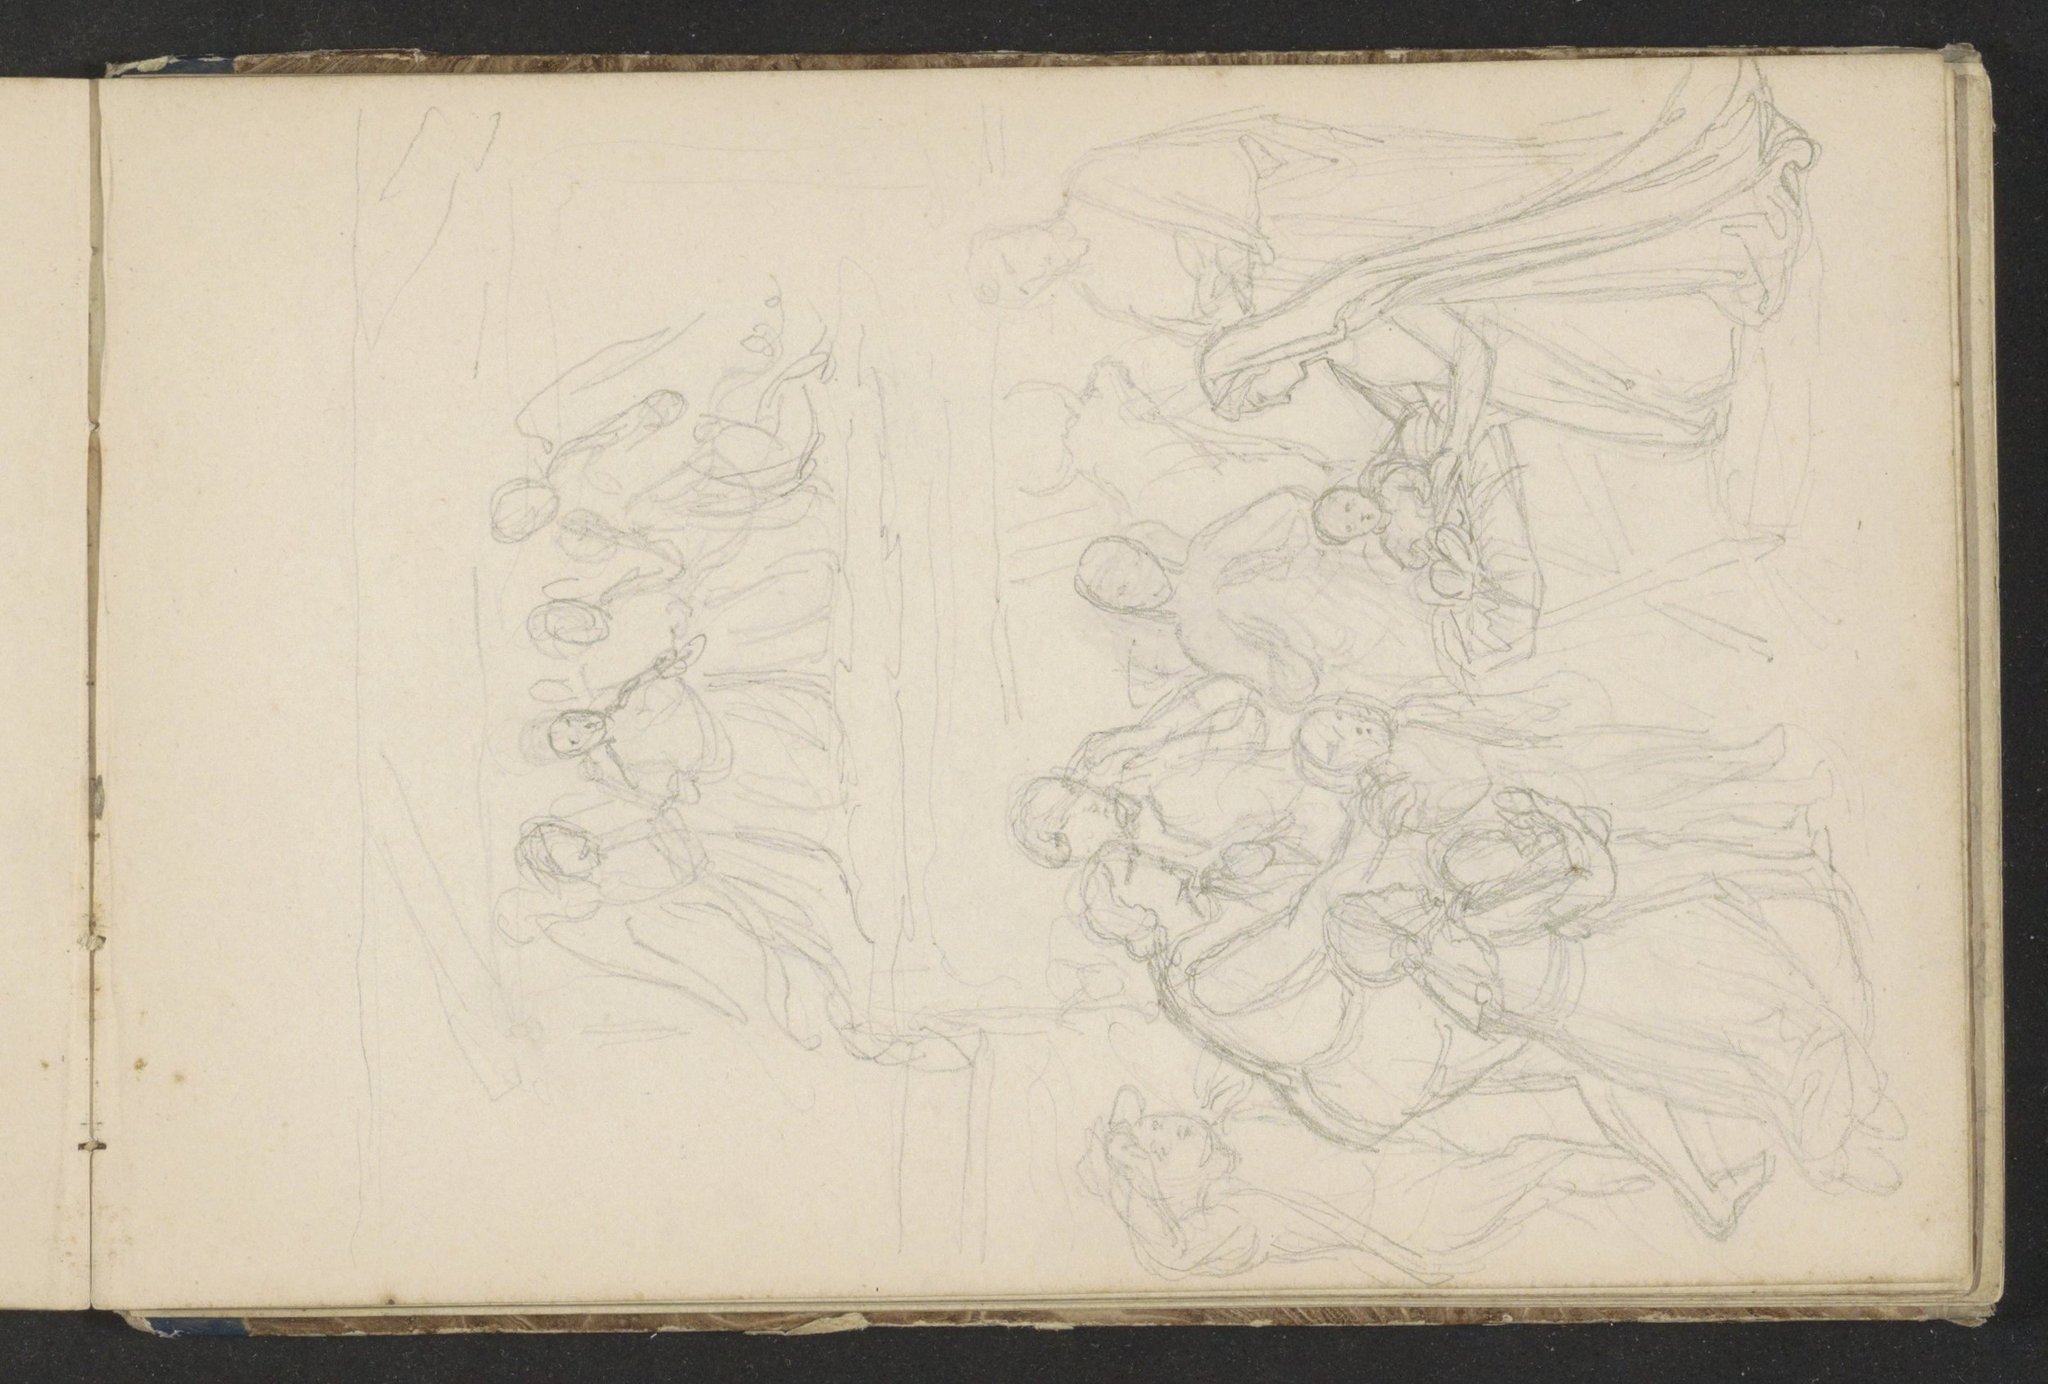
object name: sketchbook leaf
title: Geboorte van Christus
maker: Anonymous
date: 1841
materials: paper, pencil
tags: mary, joseph and the new-born christ (nativity)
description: Blad 14 recto uit een schetsboek met 33 bladen.